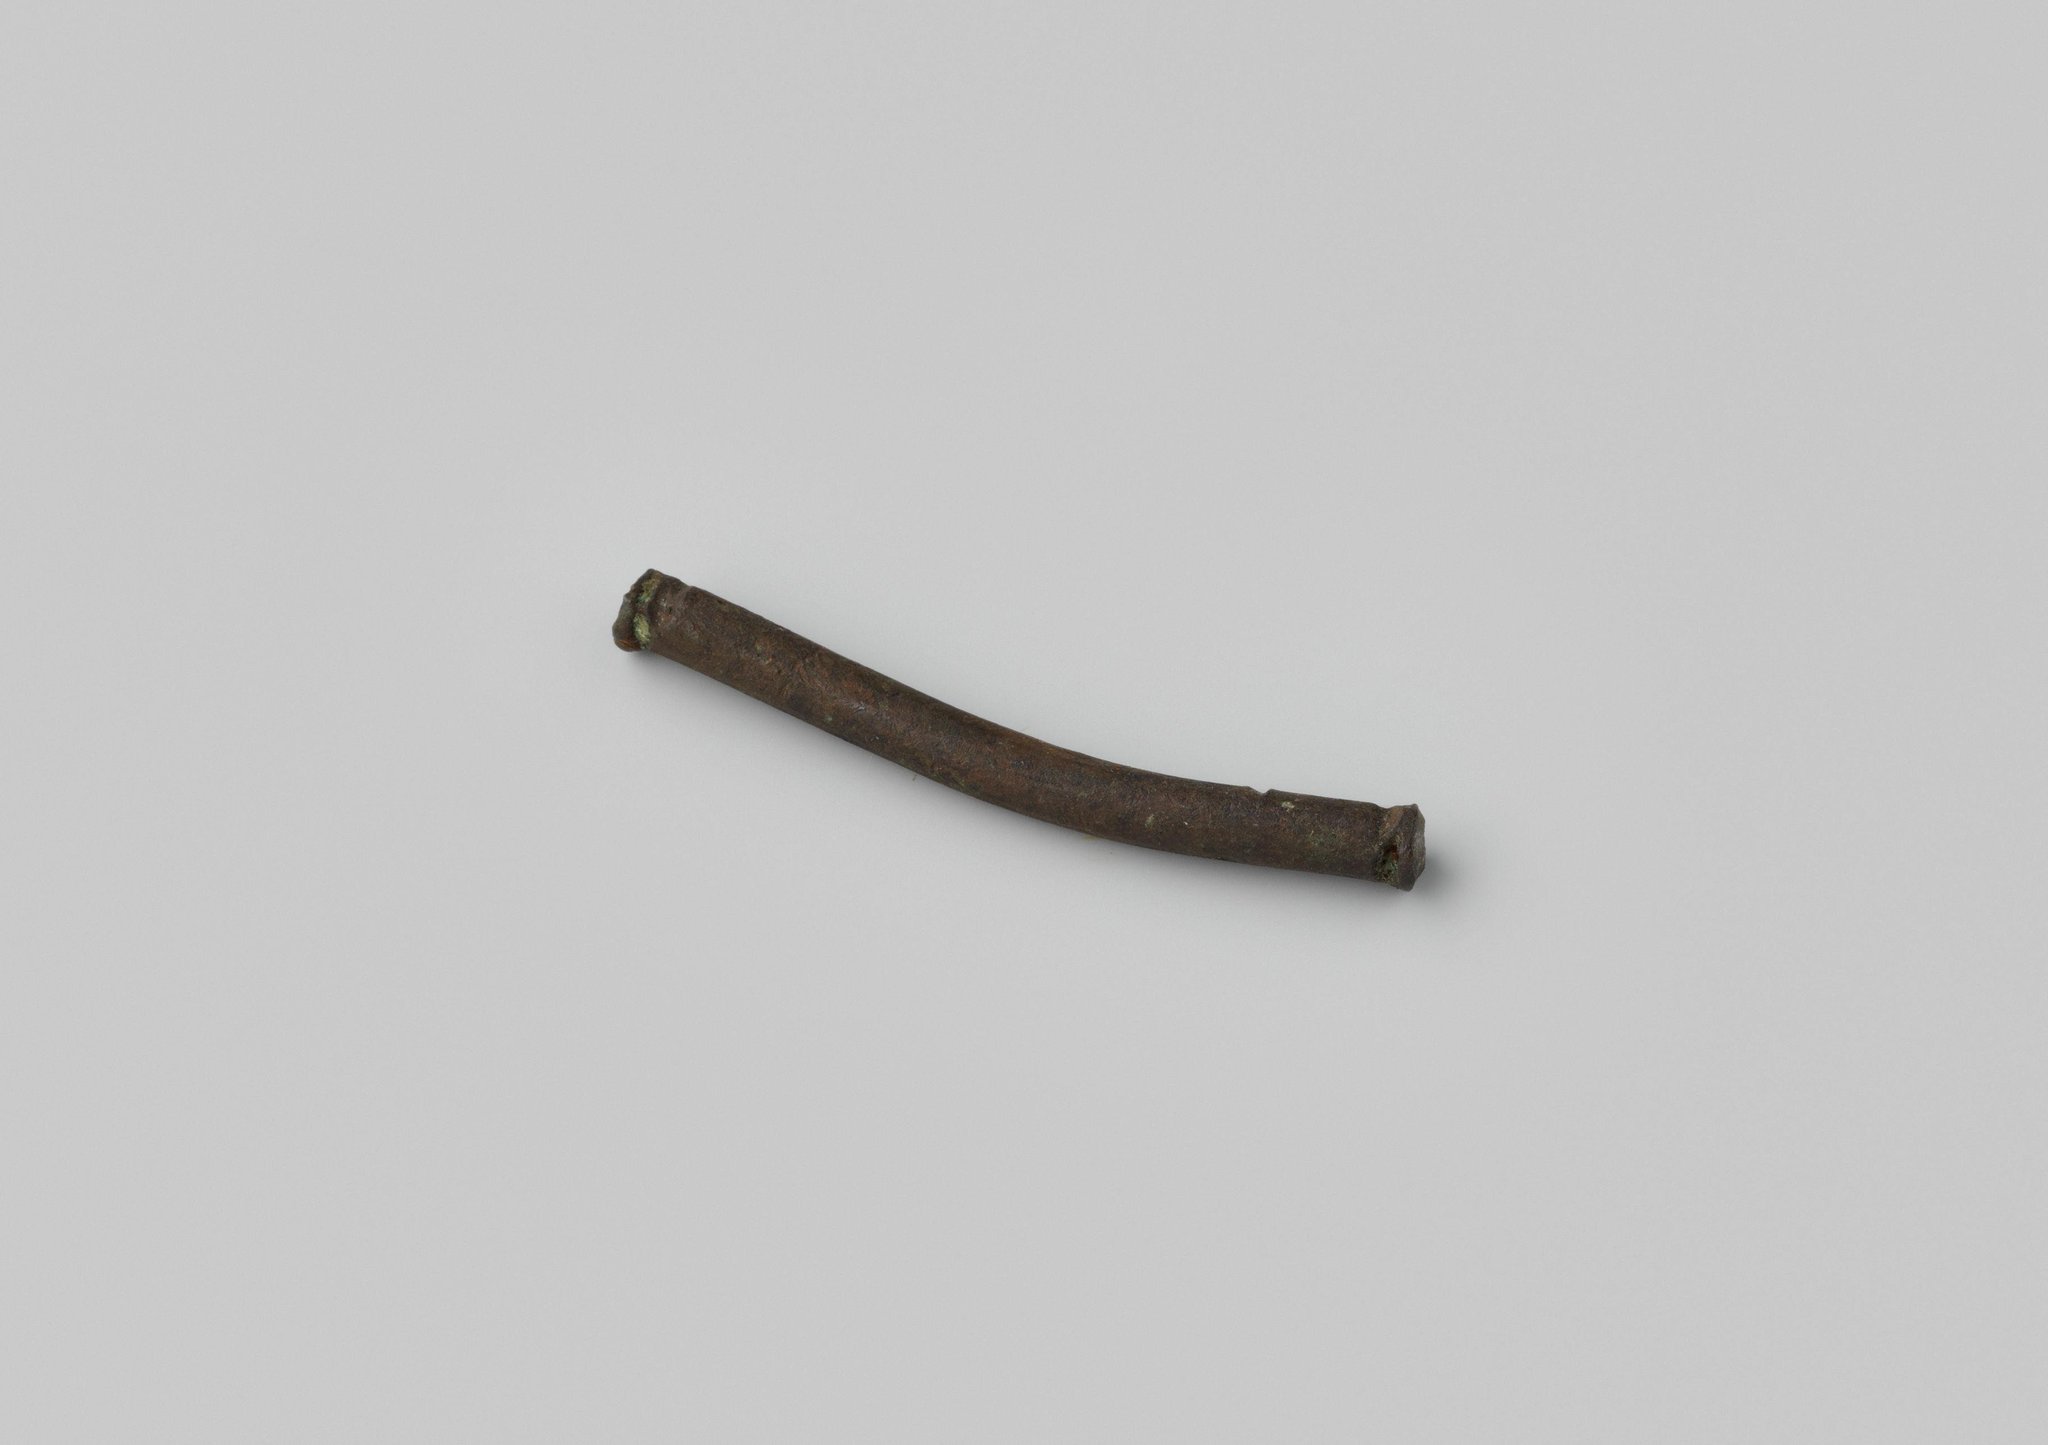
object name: part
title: Fragment of onderdeel uit het wrak van de Oost-Indiëvaarder Hollandia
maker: Anonymous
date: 1743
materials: copper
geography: netherlands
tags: verenigde oostindische compagnie, hollandia (schip), annet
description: Varied parts or fragments, bar(-shaped) fragments; slightly bent, straight notched ends.